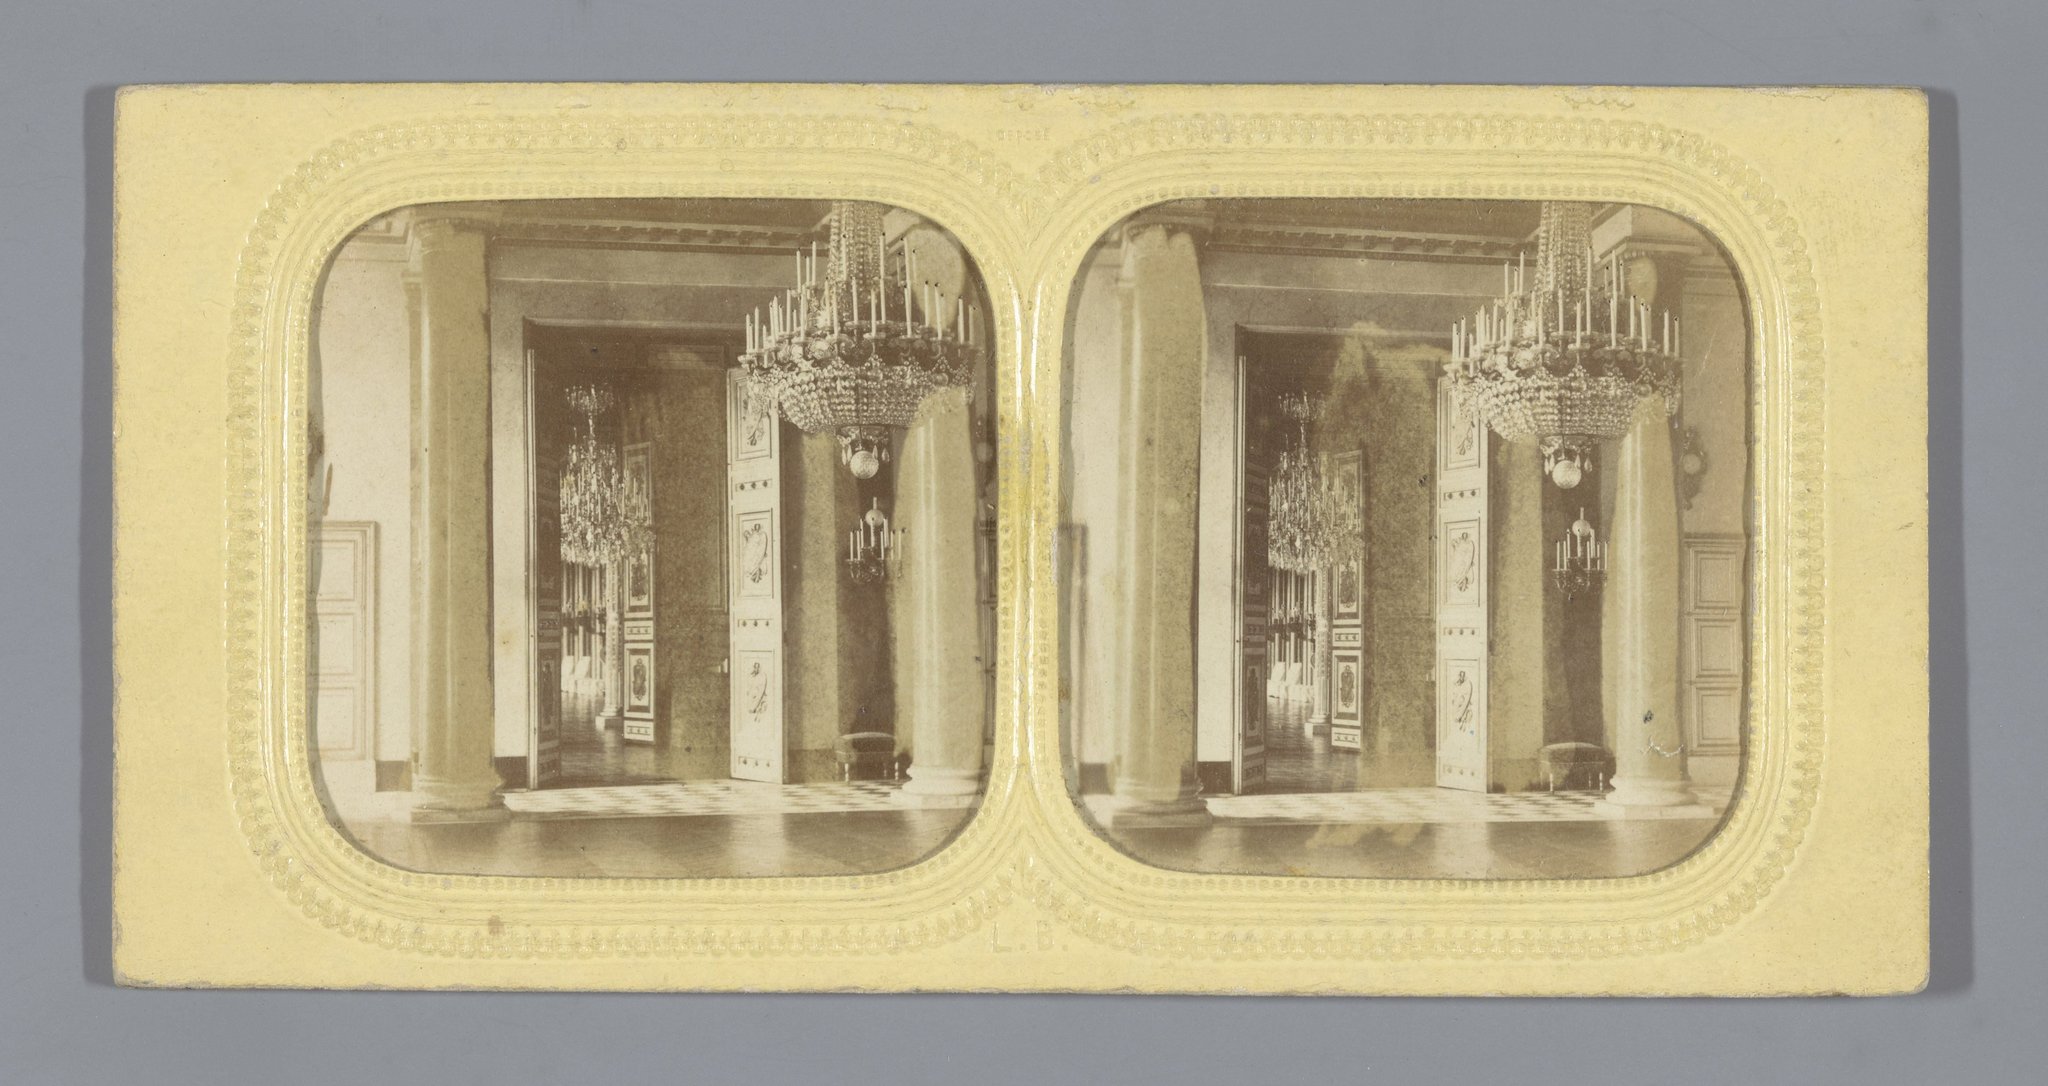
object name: tissue stereograph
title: Salle des gardes (Tuileries)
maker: l.b. (fotograaf)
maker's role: fotograaf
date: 1855-1875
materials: cardboard, paper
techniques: albumen print, hand coloring, perforating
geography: paris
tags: palace - aa - civic architecture: inside, tuileries palace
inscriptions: inscription: ‘Deposé’, inscription: ‘pmr’, inscription: ‘Carel Henny. Jan./ Jan Henny 24’, number: ‘50’